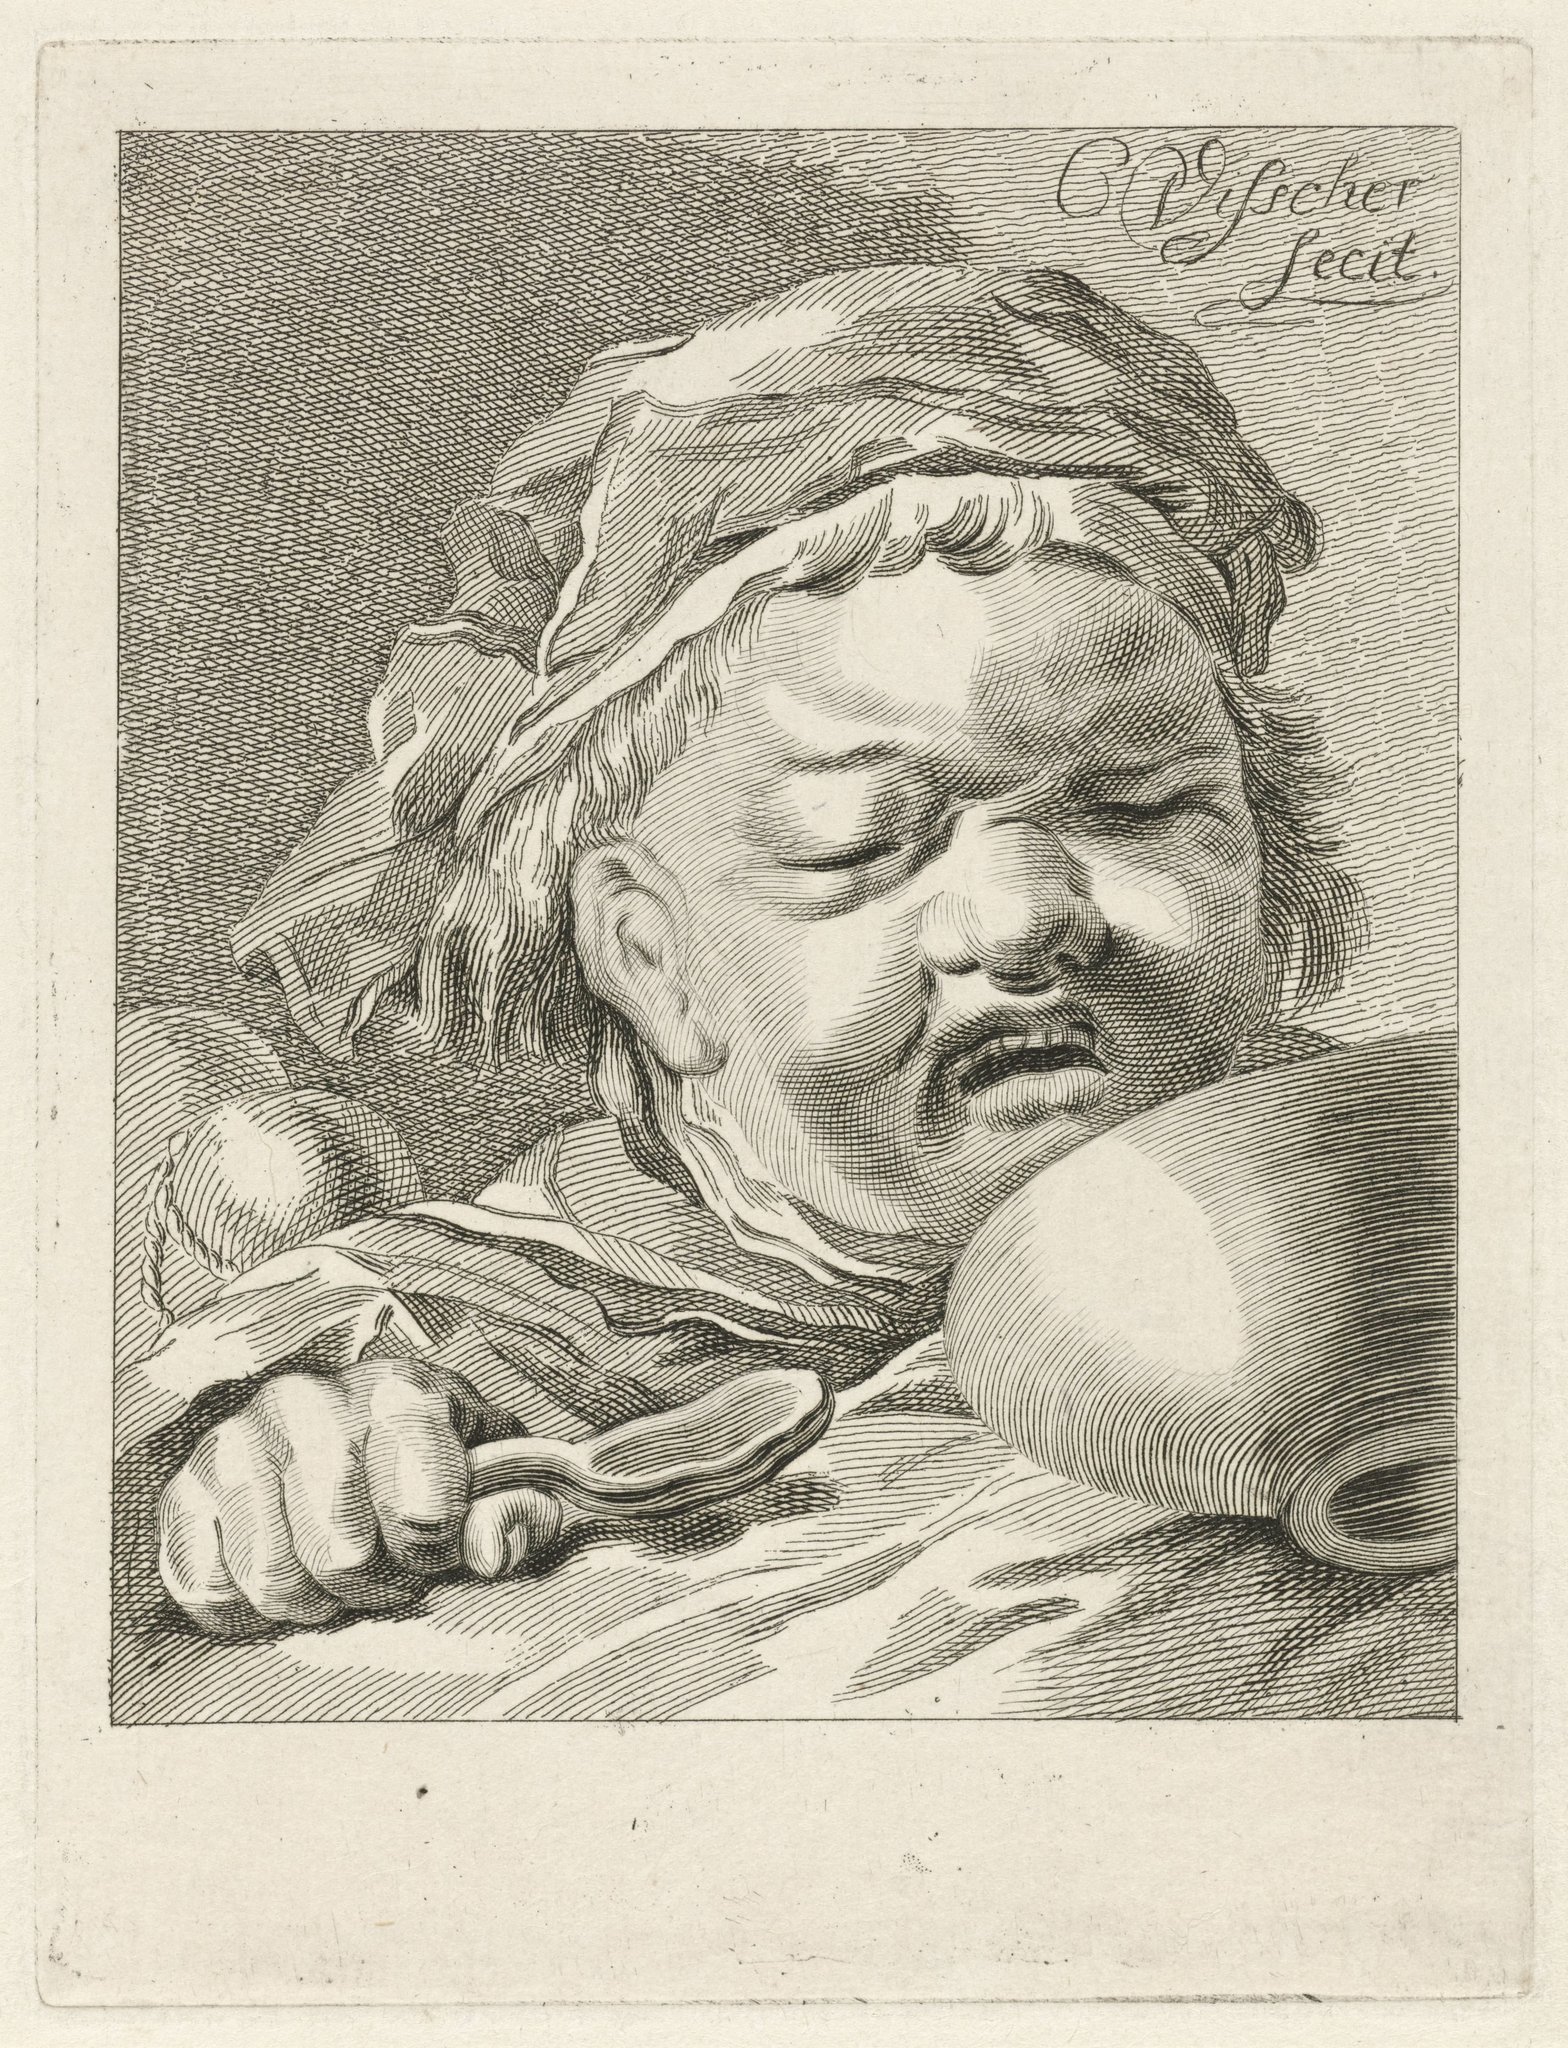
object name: print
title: Huilend kind met nap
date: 1768-1796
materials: paper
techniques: engraving, etching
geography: leiden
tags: spoon, bowl, tot, toddler ~ the ages of man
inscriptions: collector's mark: Lugt 240